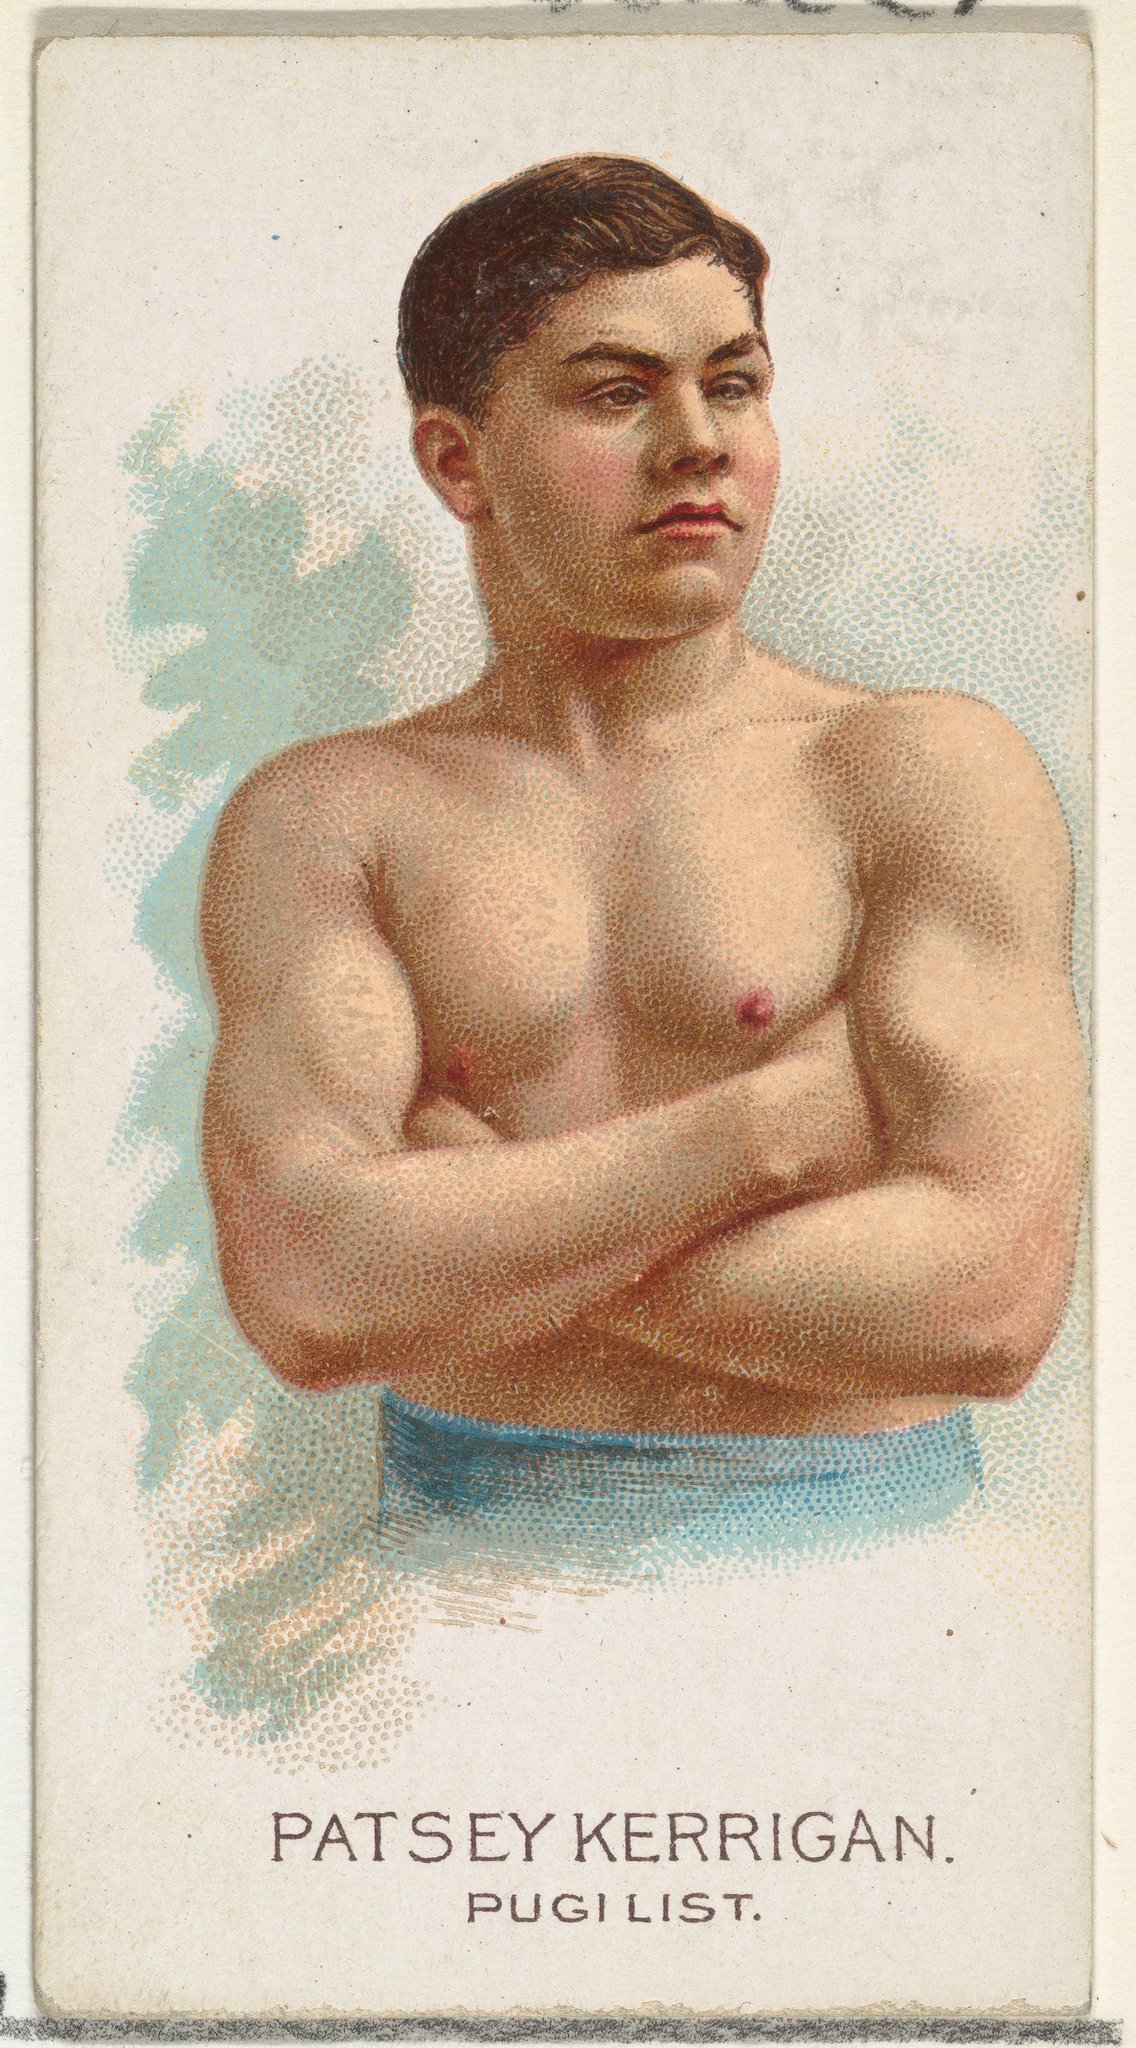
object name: print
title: Patsey Kerrigan, Pugilist, from World's Champions, Series 2 (N29) for Allen & Ginter Cigarettes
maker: allen & ginter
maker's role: publisher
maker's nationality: american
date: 1888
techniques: color lithograph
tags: men,portraits,athletes